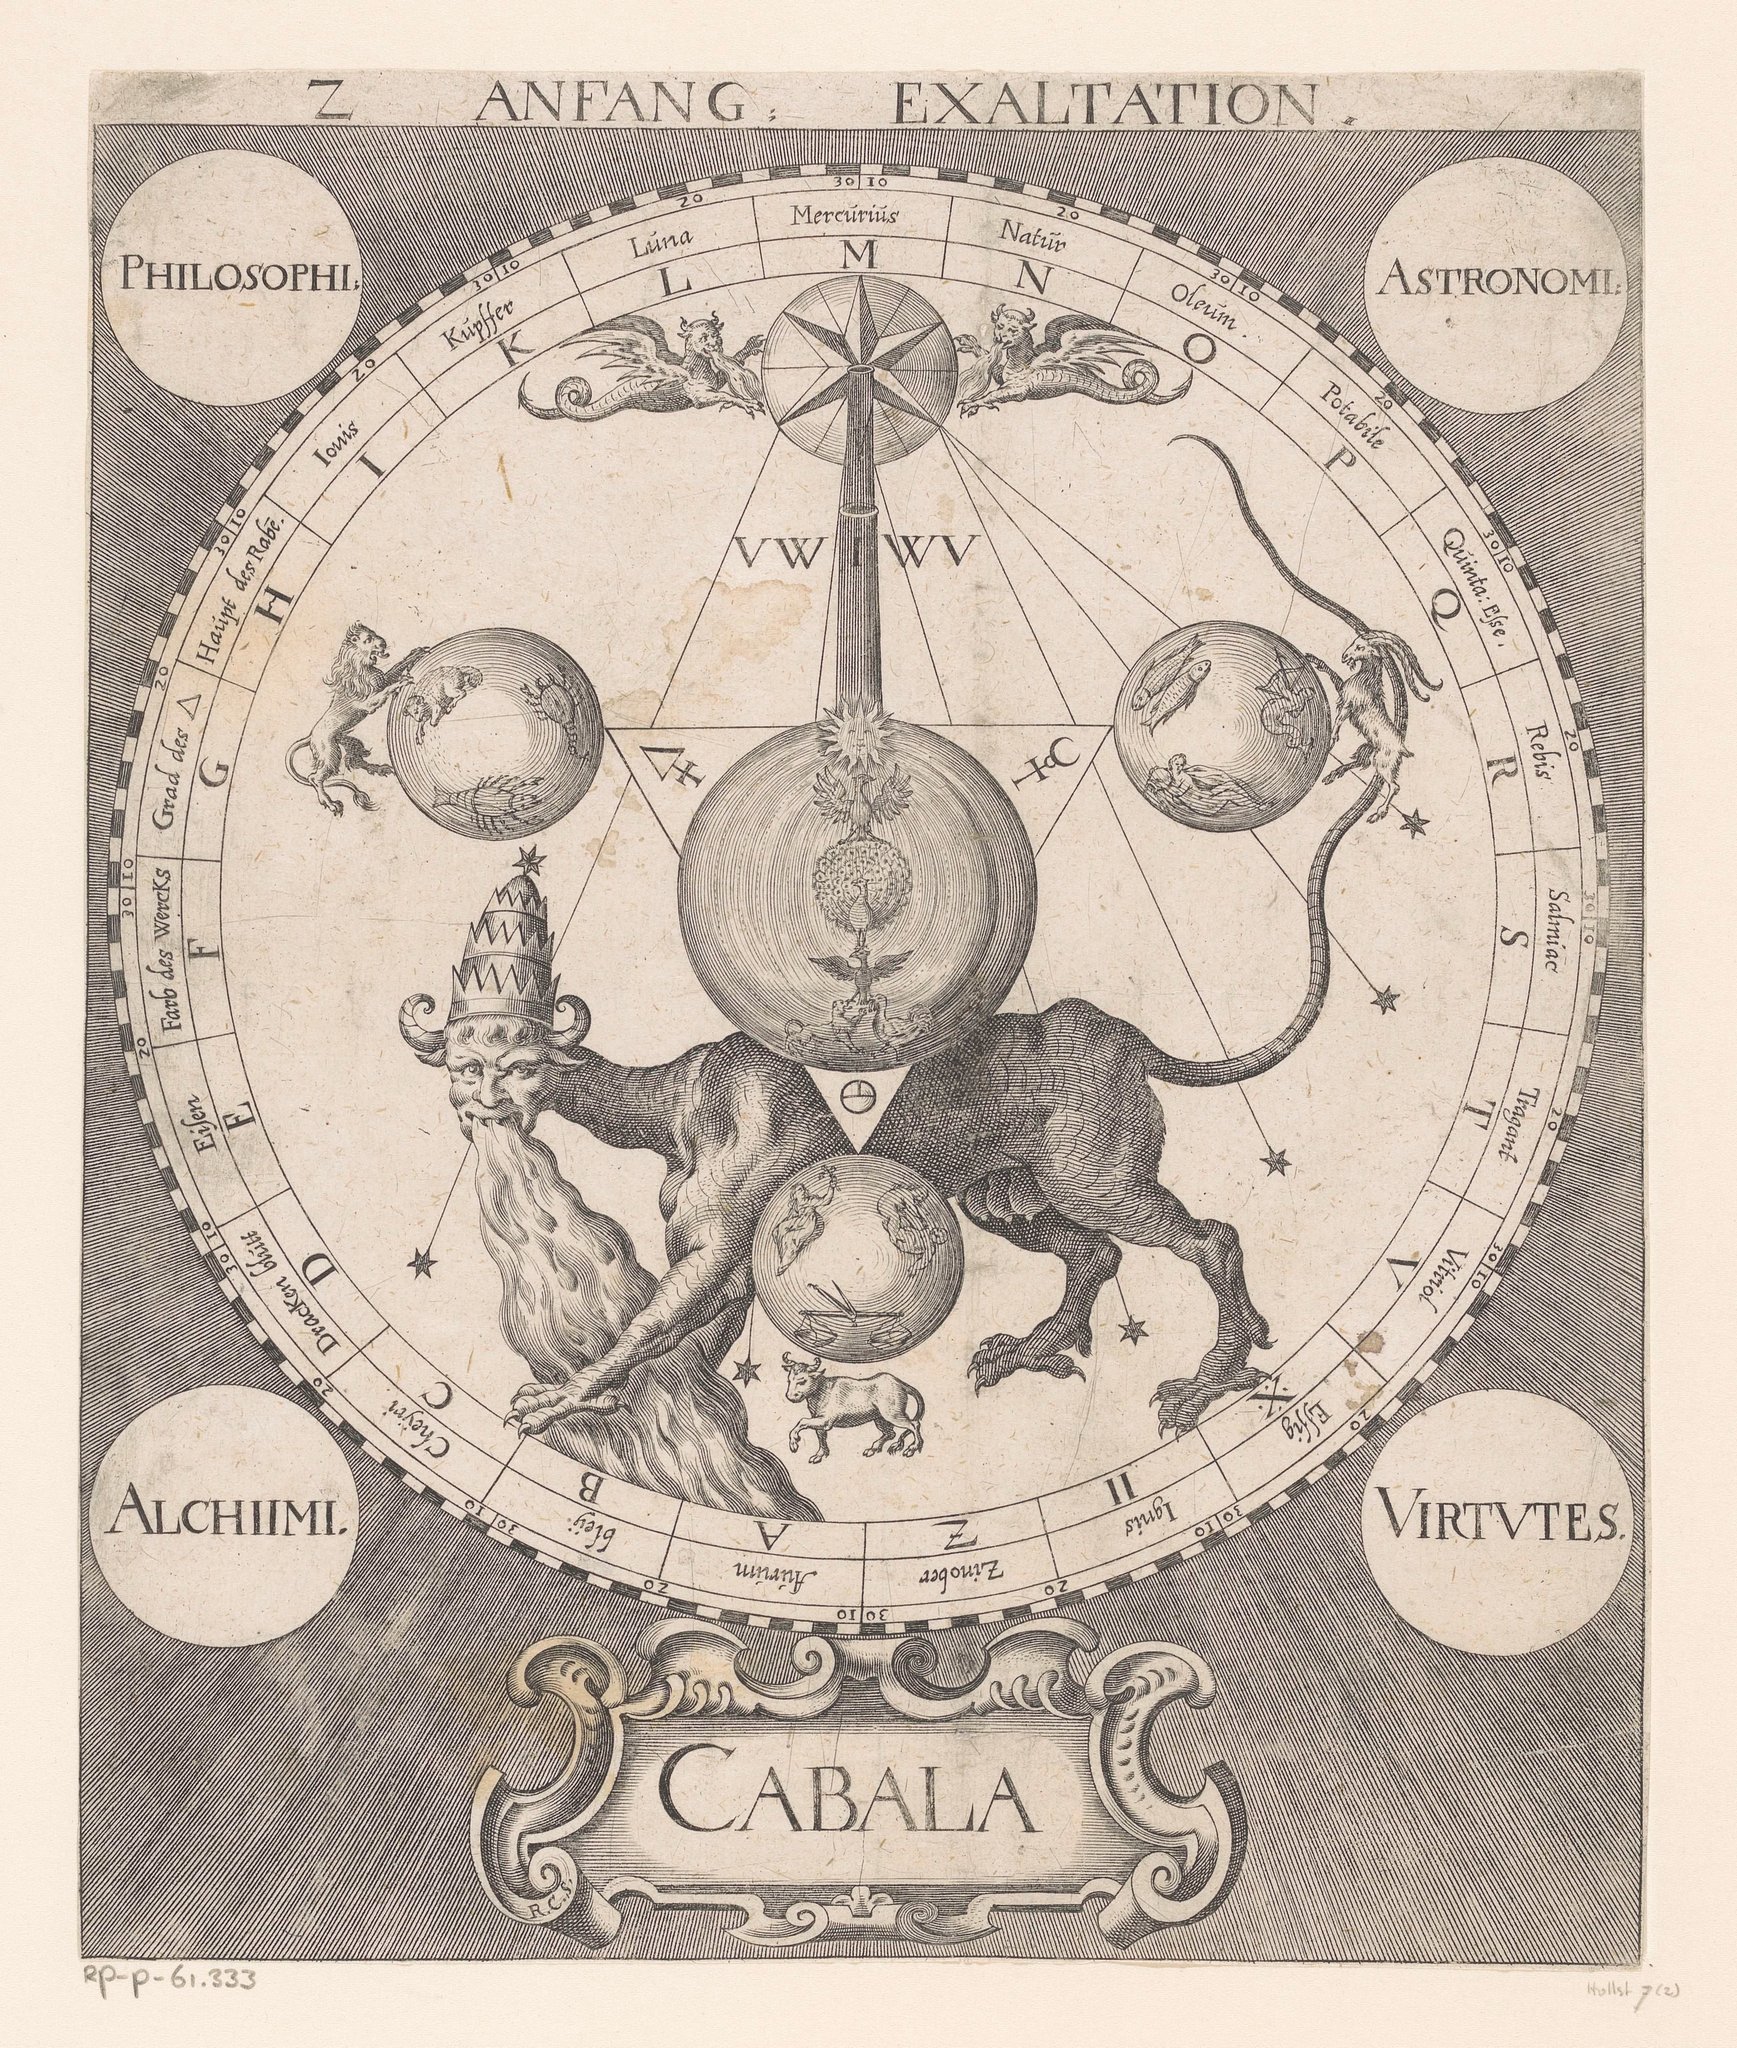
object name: print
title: Anfang Exaltation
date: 1615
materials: paper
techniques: engraving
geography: augsburg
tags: dragon (large fabulous serpent, sometimes with wings and legs), alchemistic symbols, bottles: philosophical egg (ovum philosophicum), zodiac; the twelve zodiacal signs together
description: Prent uit: Michelspacher, Stephan. Cabala, Spiegel der Kunst unnd Natur: in Alchymia (...). Augsburg: Hans Schultes, 1615. De prent toont het door Michelspacher beschreven proces van de vervaardiging van de zogenaamde 'Steen der Wijzen'.